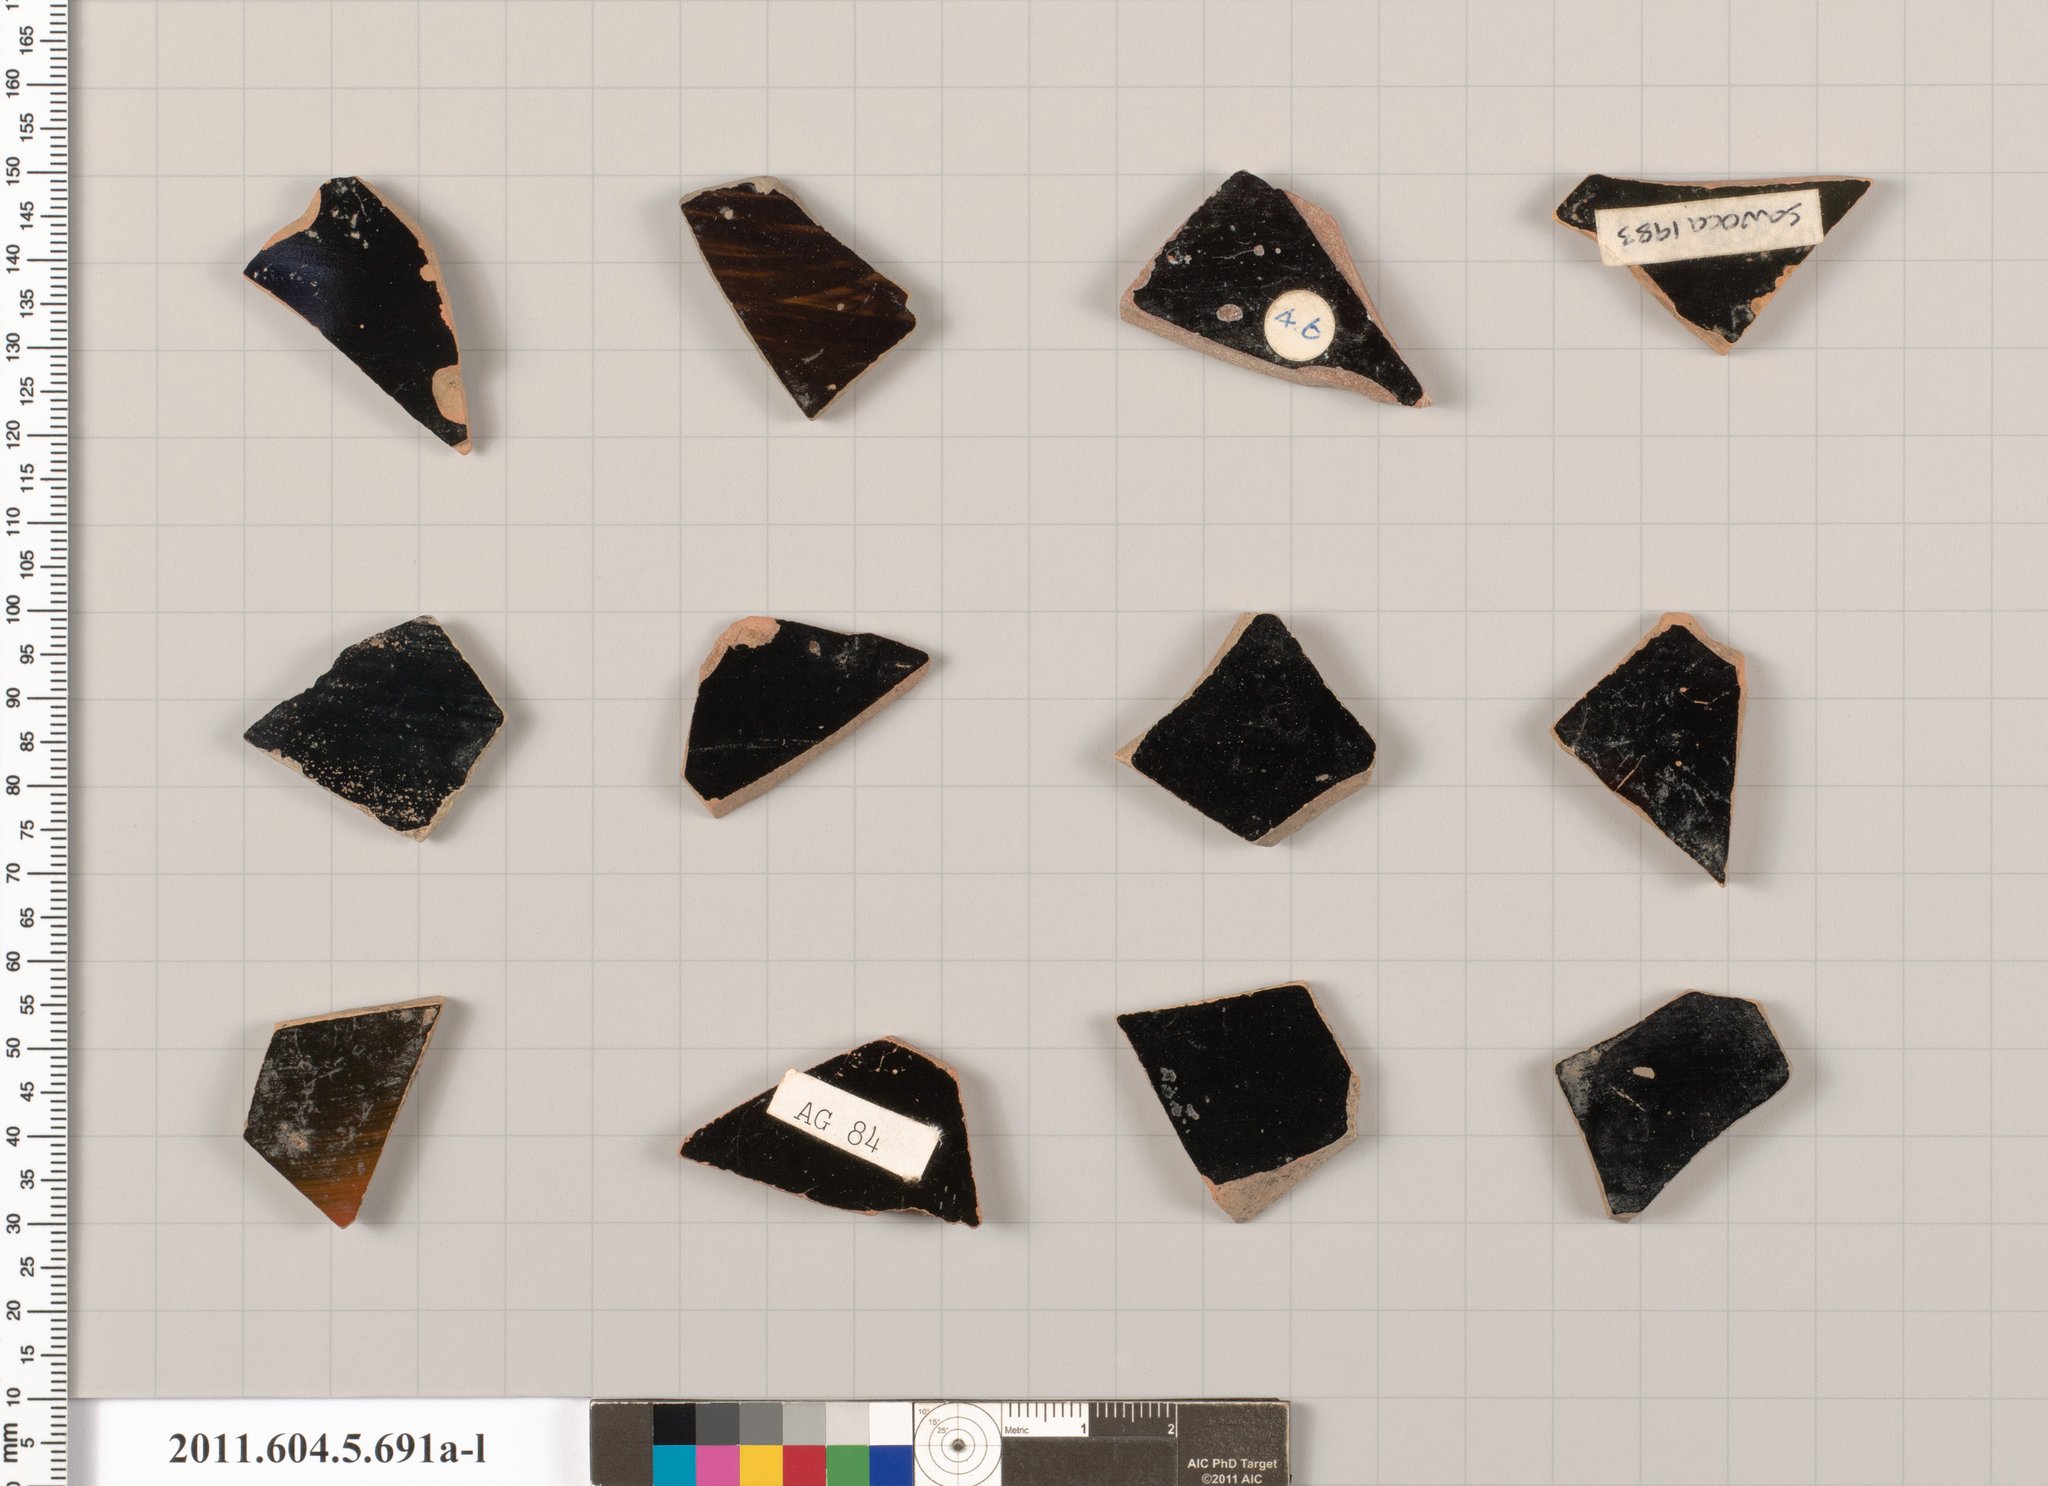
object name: kylix fragment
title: Terracotta fragments of kylikes (drinking cups)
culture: greek, attic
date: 600-401 BCE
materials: terracotta